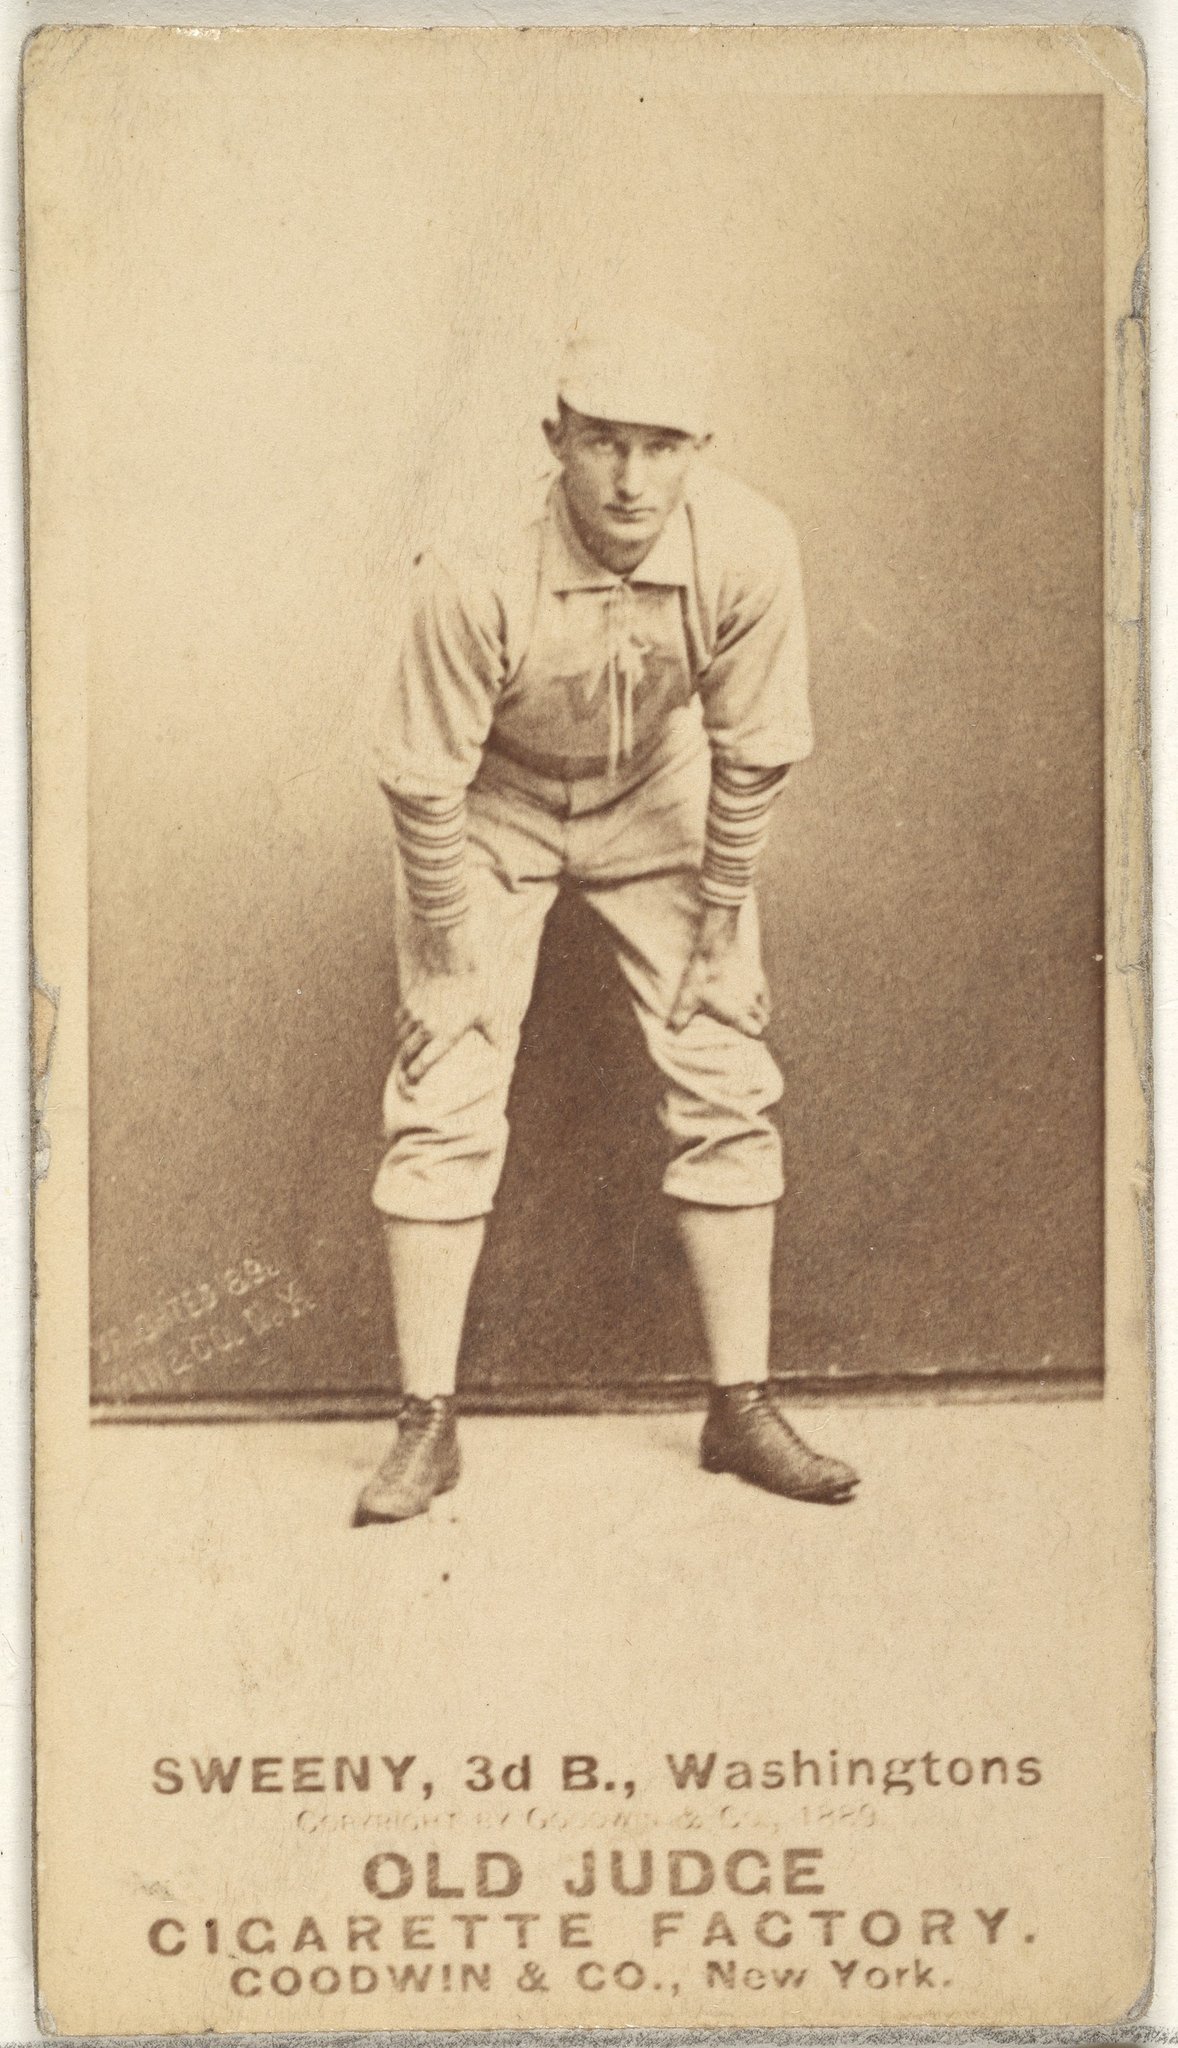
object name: baseball card, photograph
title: Peter Jay "Pete" Sweeney, 3rd Base, Washington Nationals, from the Old Judge series (N172) for Old Judge Cigarettes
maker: goodwin & company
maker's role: publisher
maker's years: 1850-1950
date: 1889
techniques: albumen silver print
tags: men,portraits,baseball,athletes